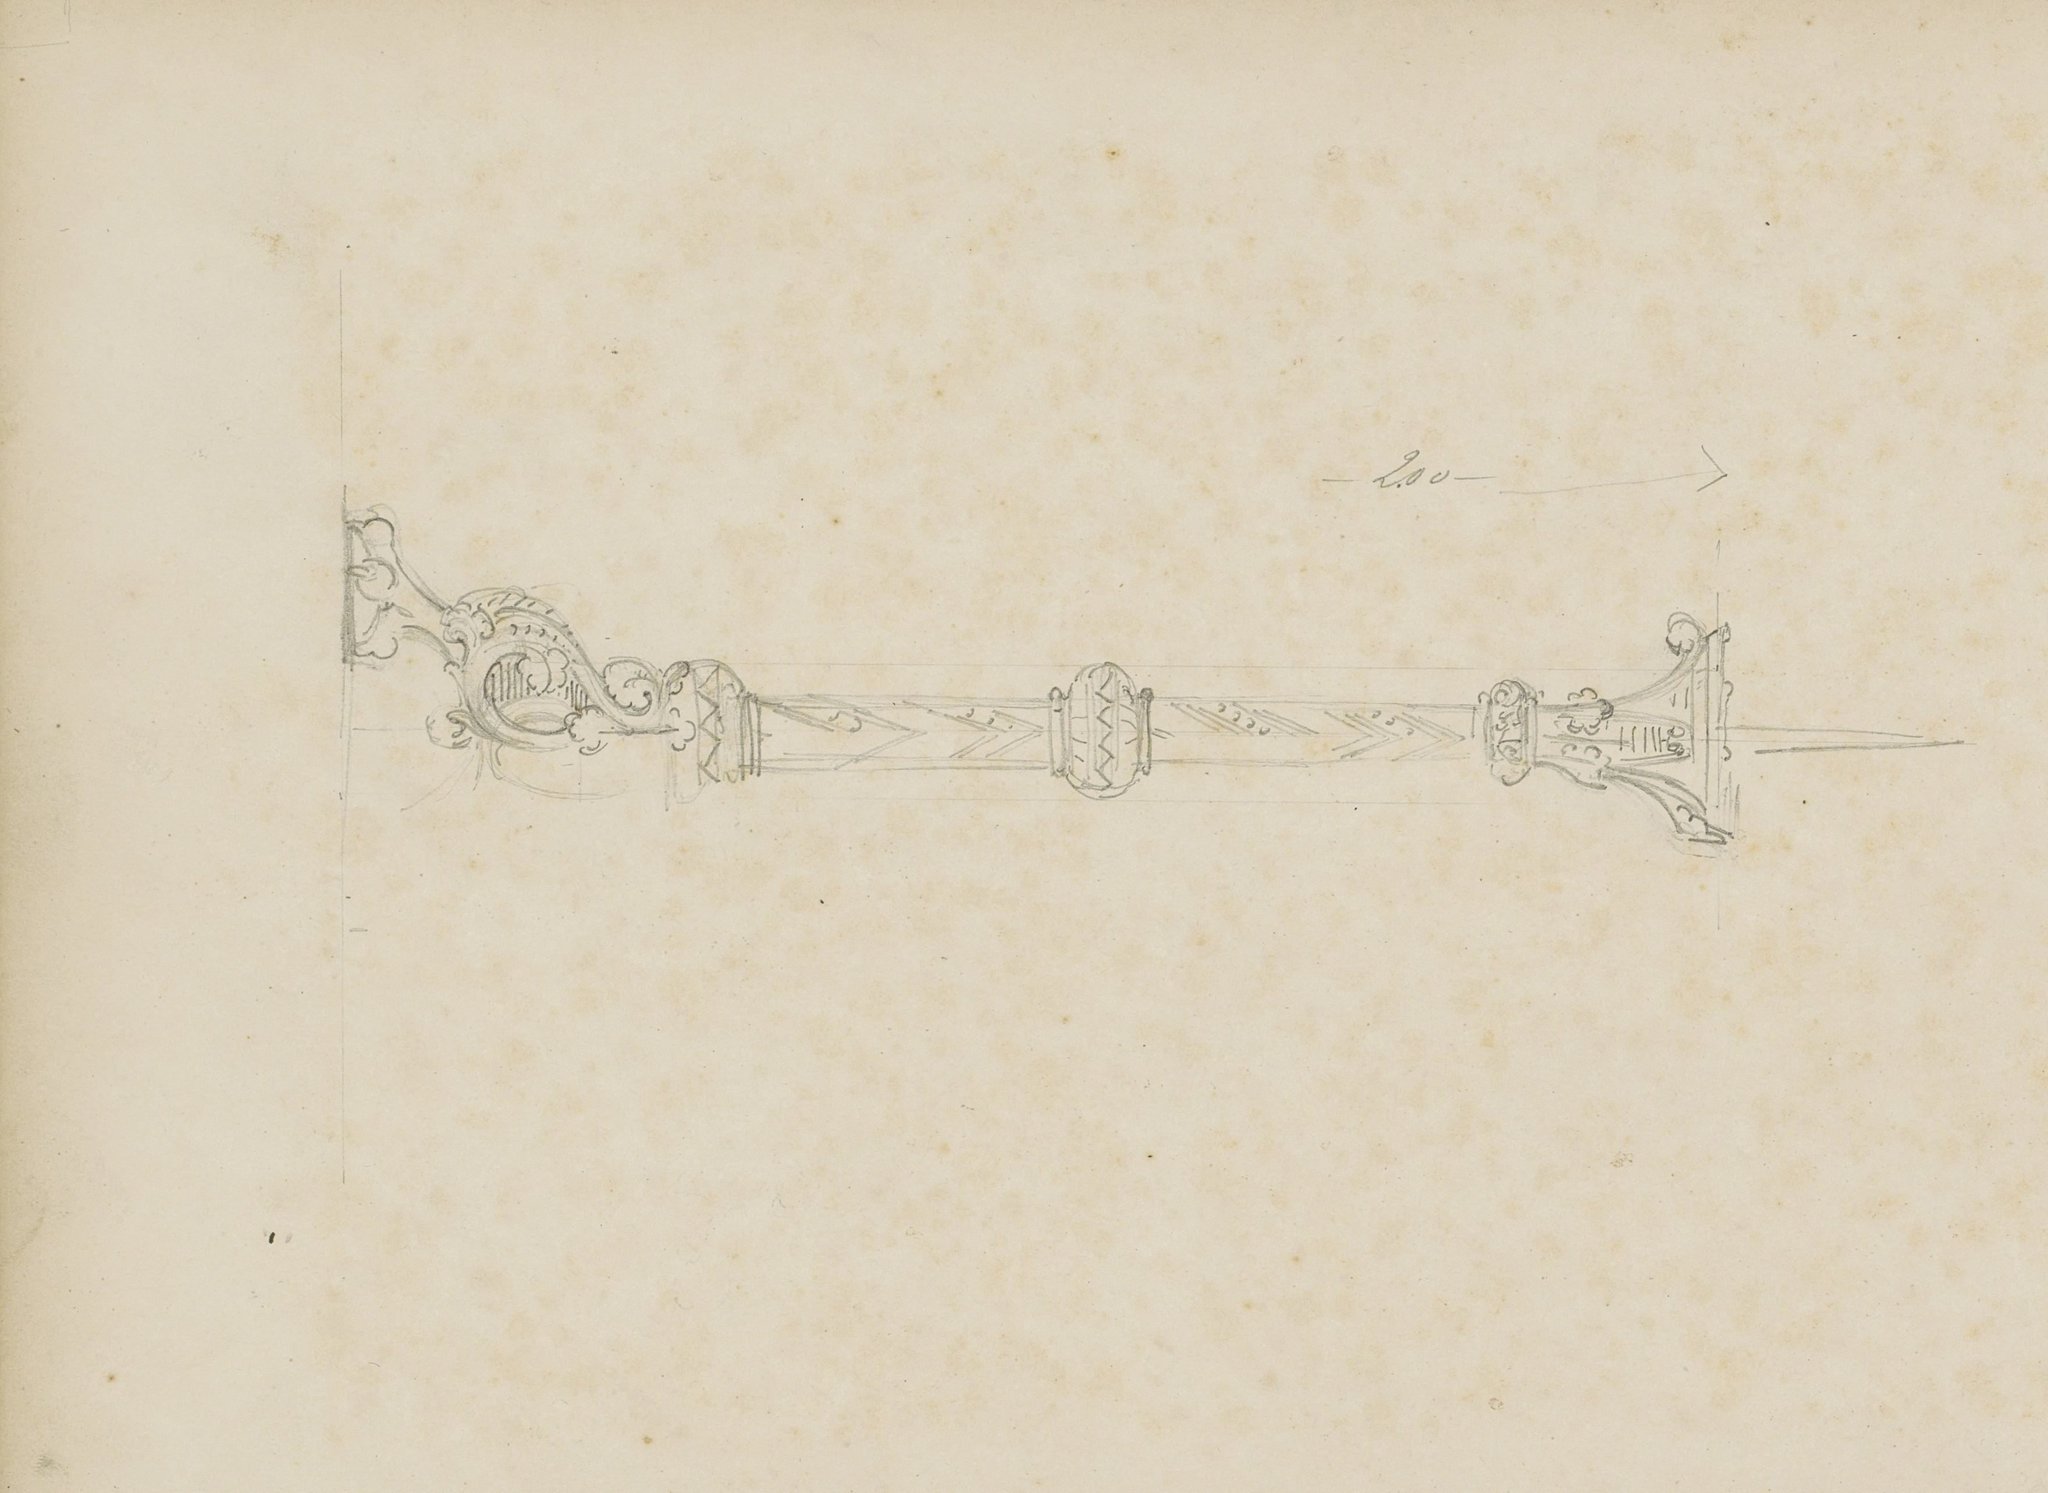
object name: sketchbook leaf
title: Kandelaar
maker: pierre joseph hubert cuypers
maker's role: draughtsman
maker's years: 1827-1921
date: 1857-1859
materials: paper, pencil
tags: candlestick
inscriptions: annotation: ‘2.00’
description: Blad 62 verso uit een schetsboek met 77 bladen.